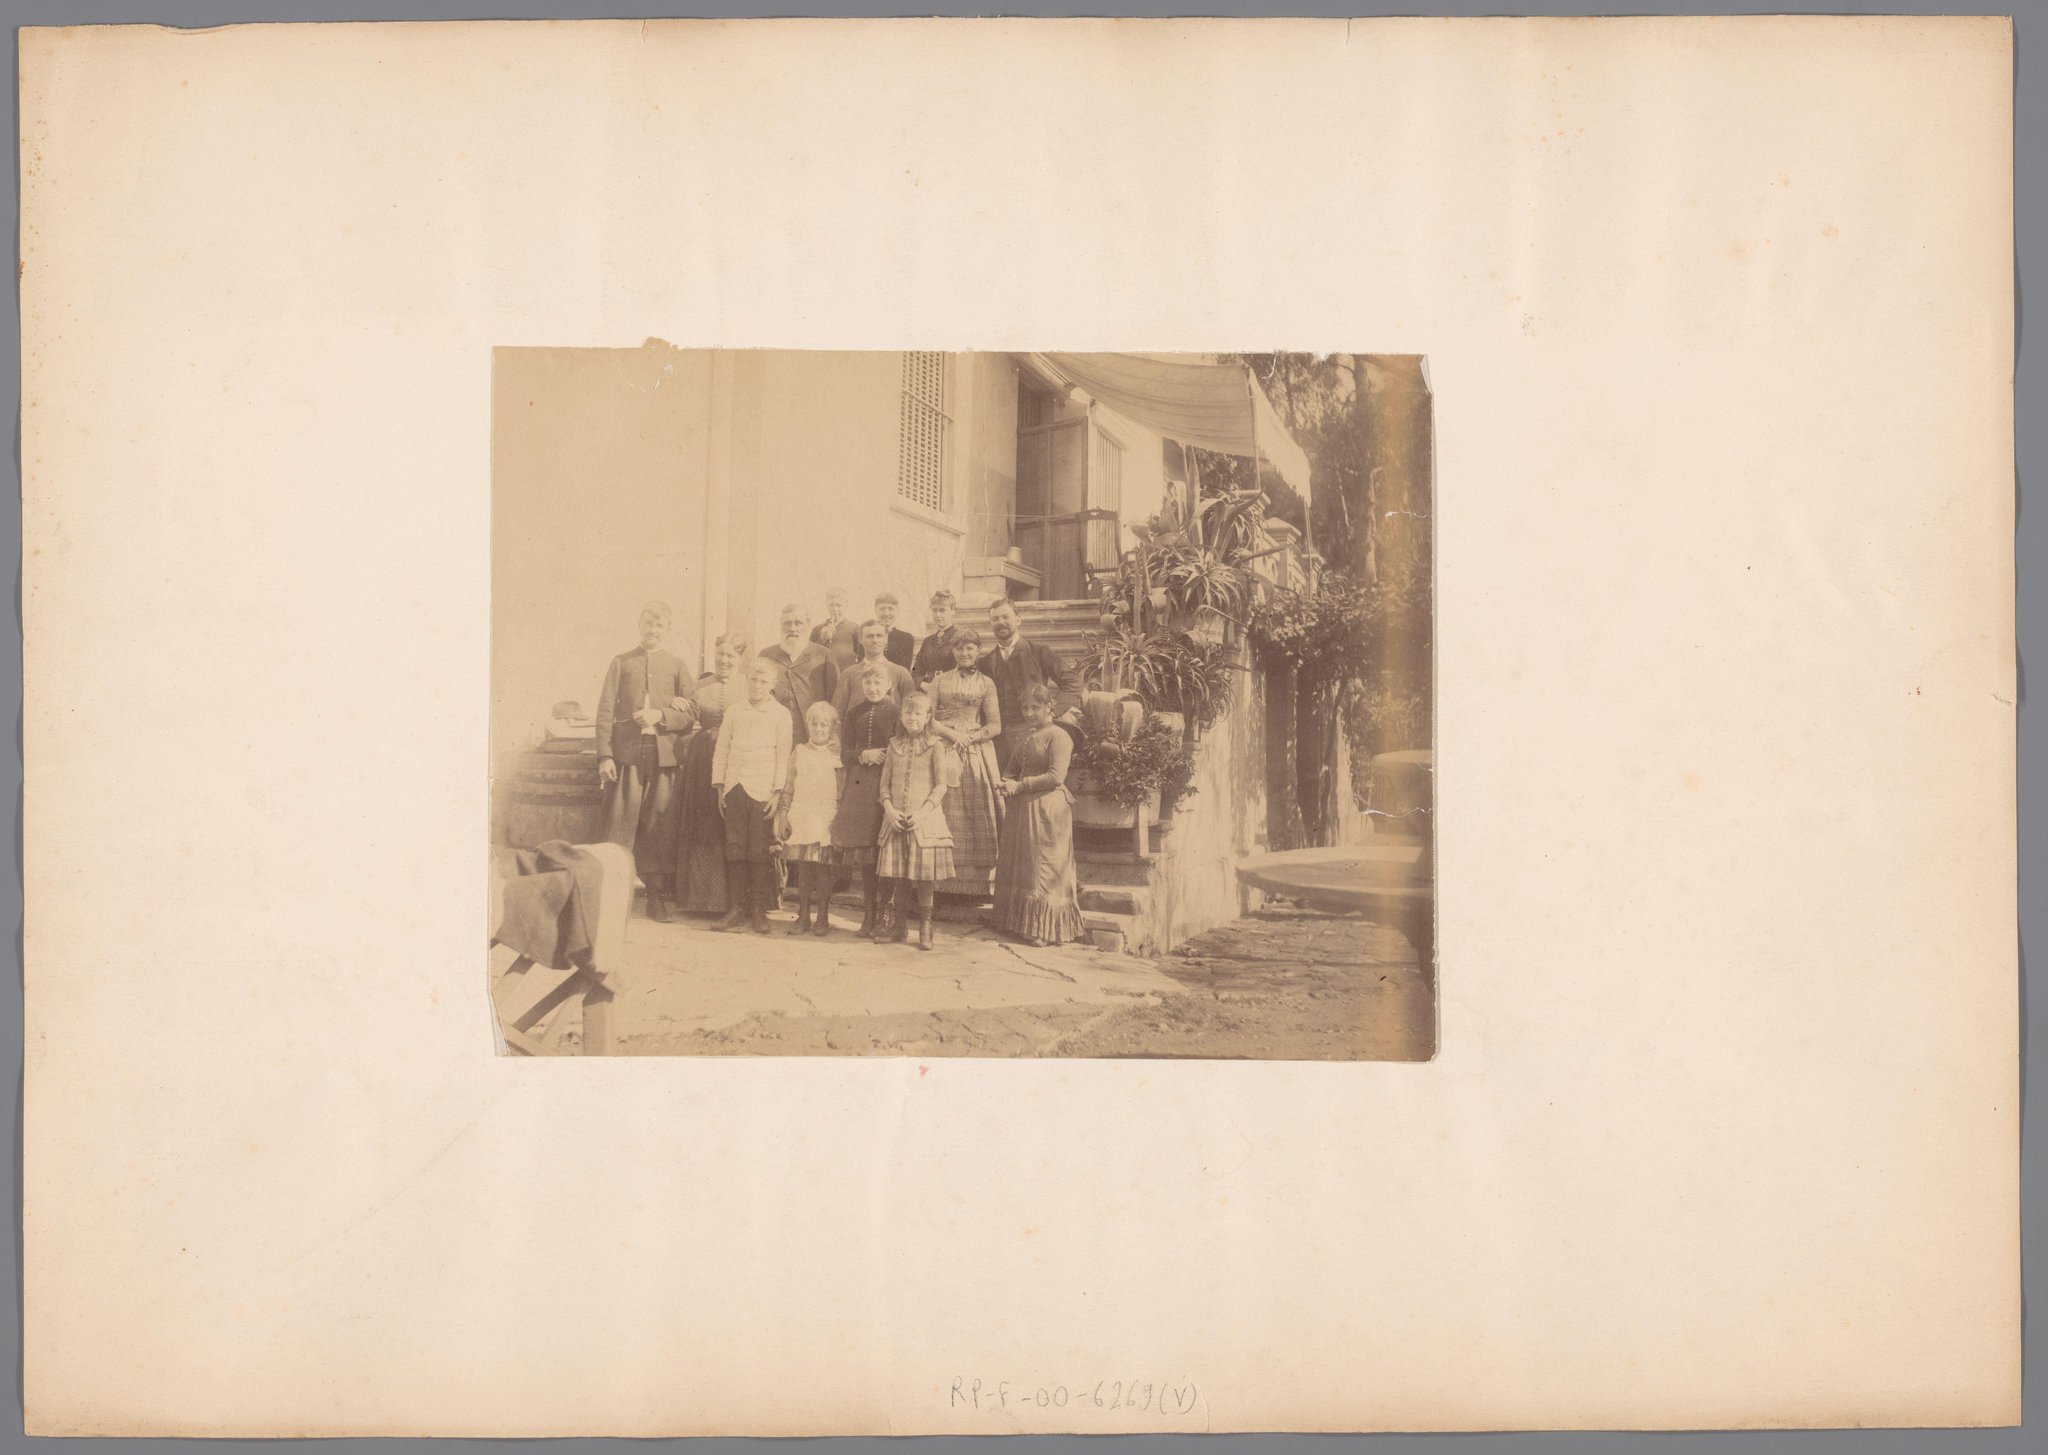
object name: photograph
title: Foto van familie op trappen voor een huis, plaats onbekend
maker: Anonymous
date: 1880-1910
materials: paper, photographic support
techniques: albumen print